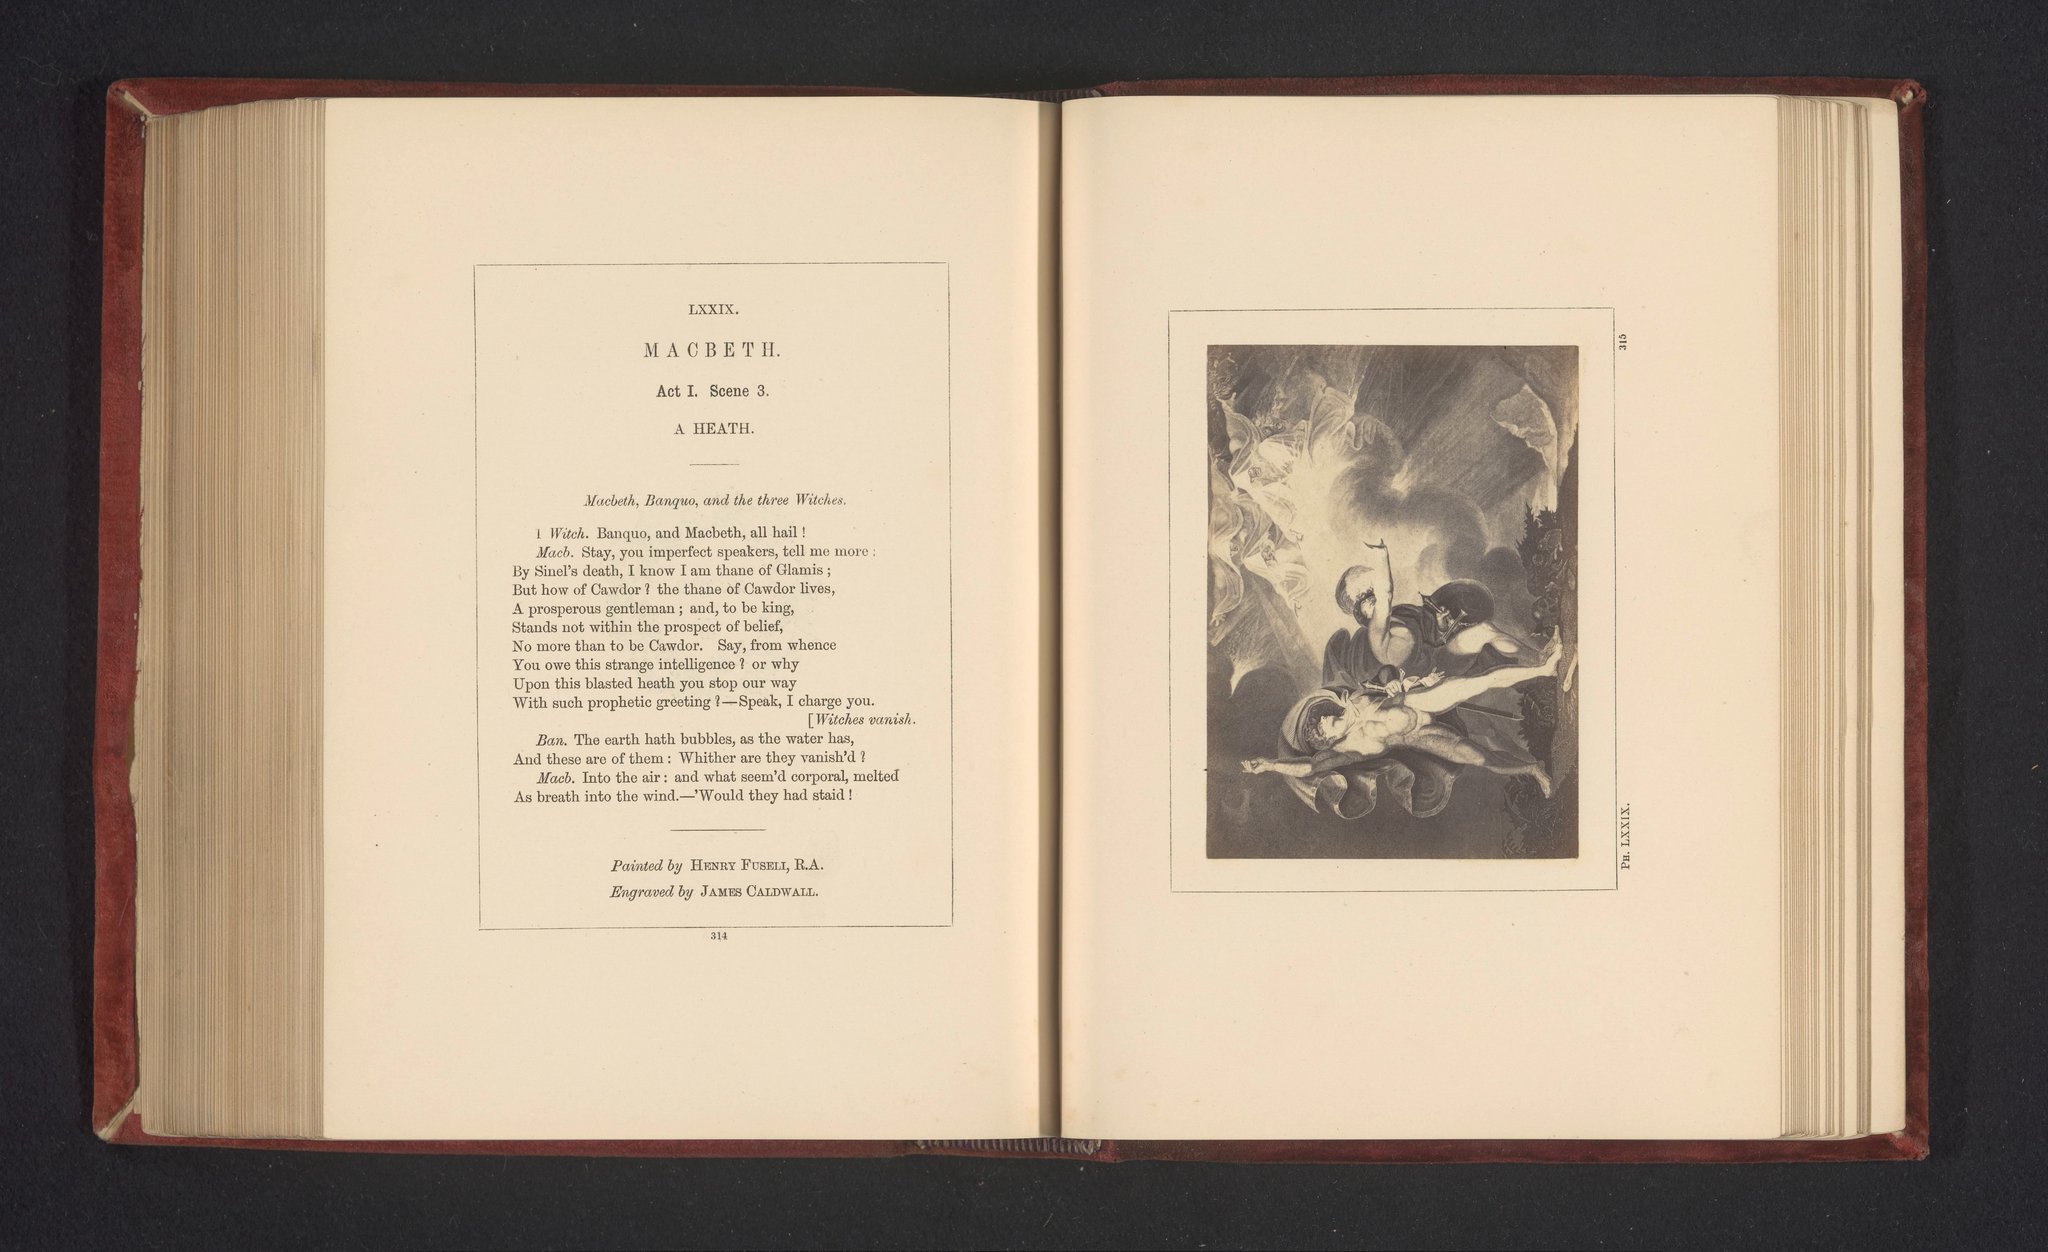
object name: page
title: Fotoreproductie van een prent naar een schilderij door Johann Heinrich Füssli, voorstellend een scene uit Macbeth door William Shakespeare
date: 1854-1864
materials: photographic support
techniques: albumen print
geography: london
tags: macbeth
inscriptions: number: ‘Ph. LXXIX. 315’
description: Te zien is akte I, scene 3 met Macbeth, Banquo en de drie heksen.